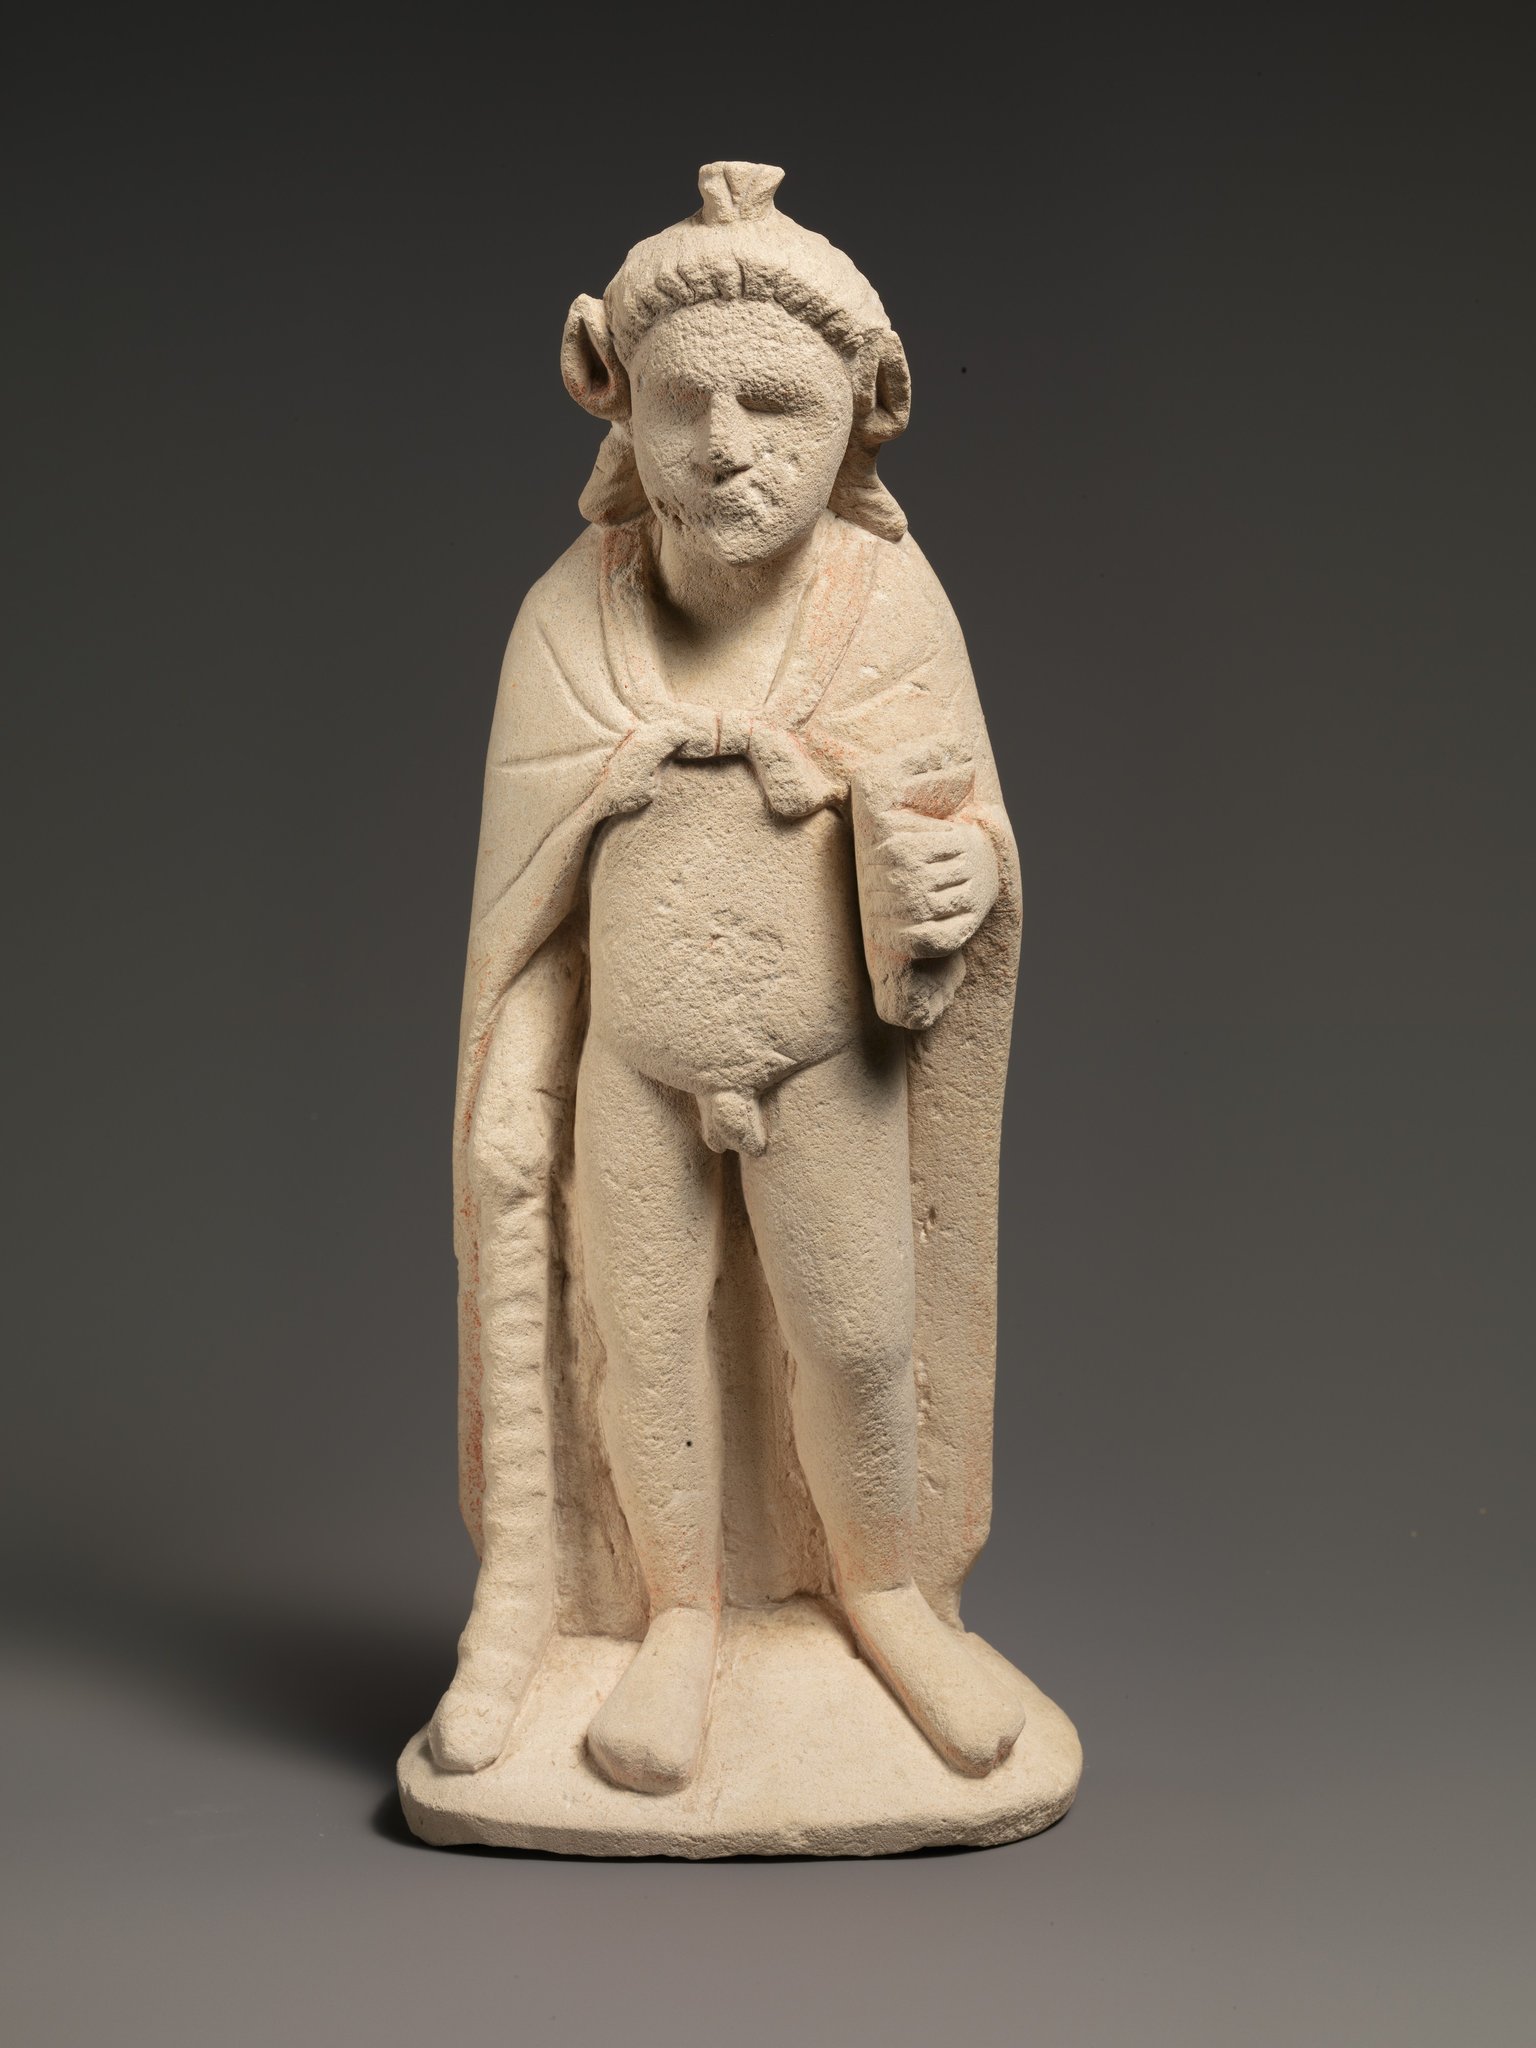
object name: statue of pan or melanthios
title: Limestone statuette of Pan or Opaon Melanthios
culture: cypriot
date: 300-201 BCE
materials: limestone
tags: men